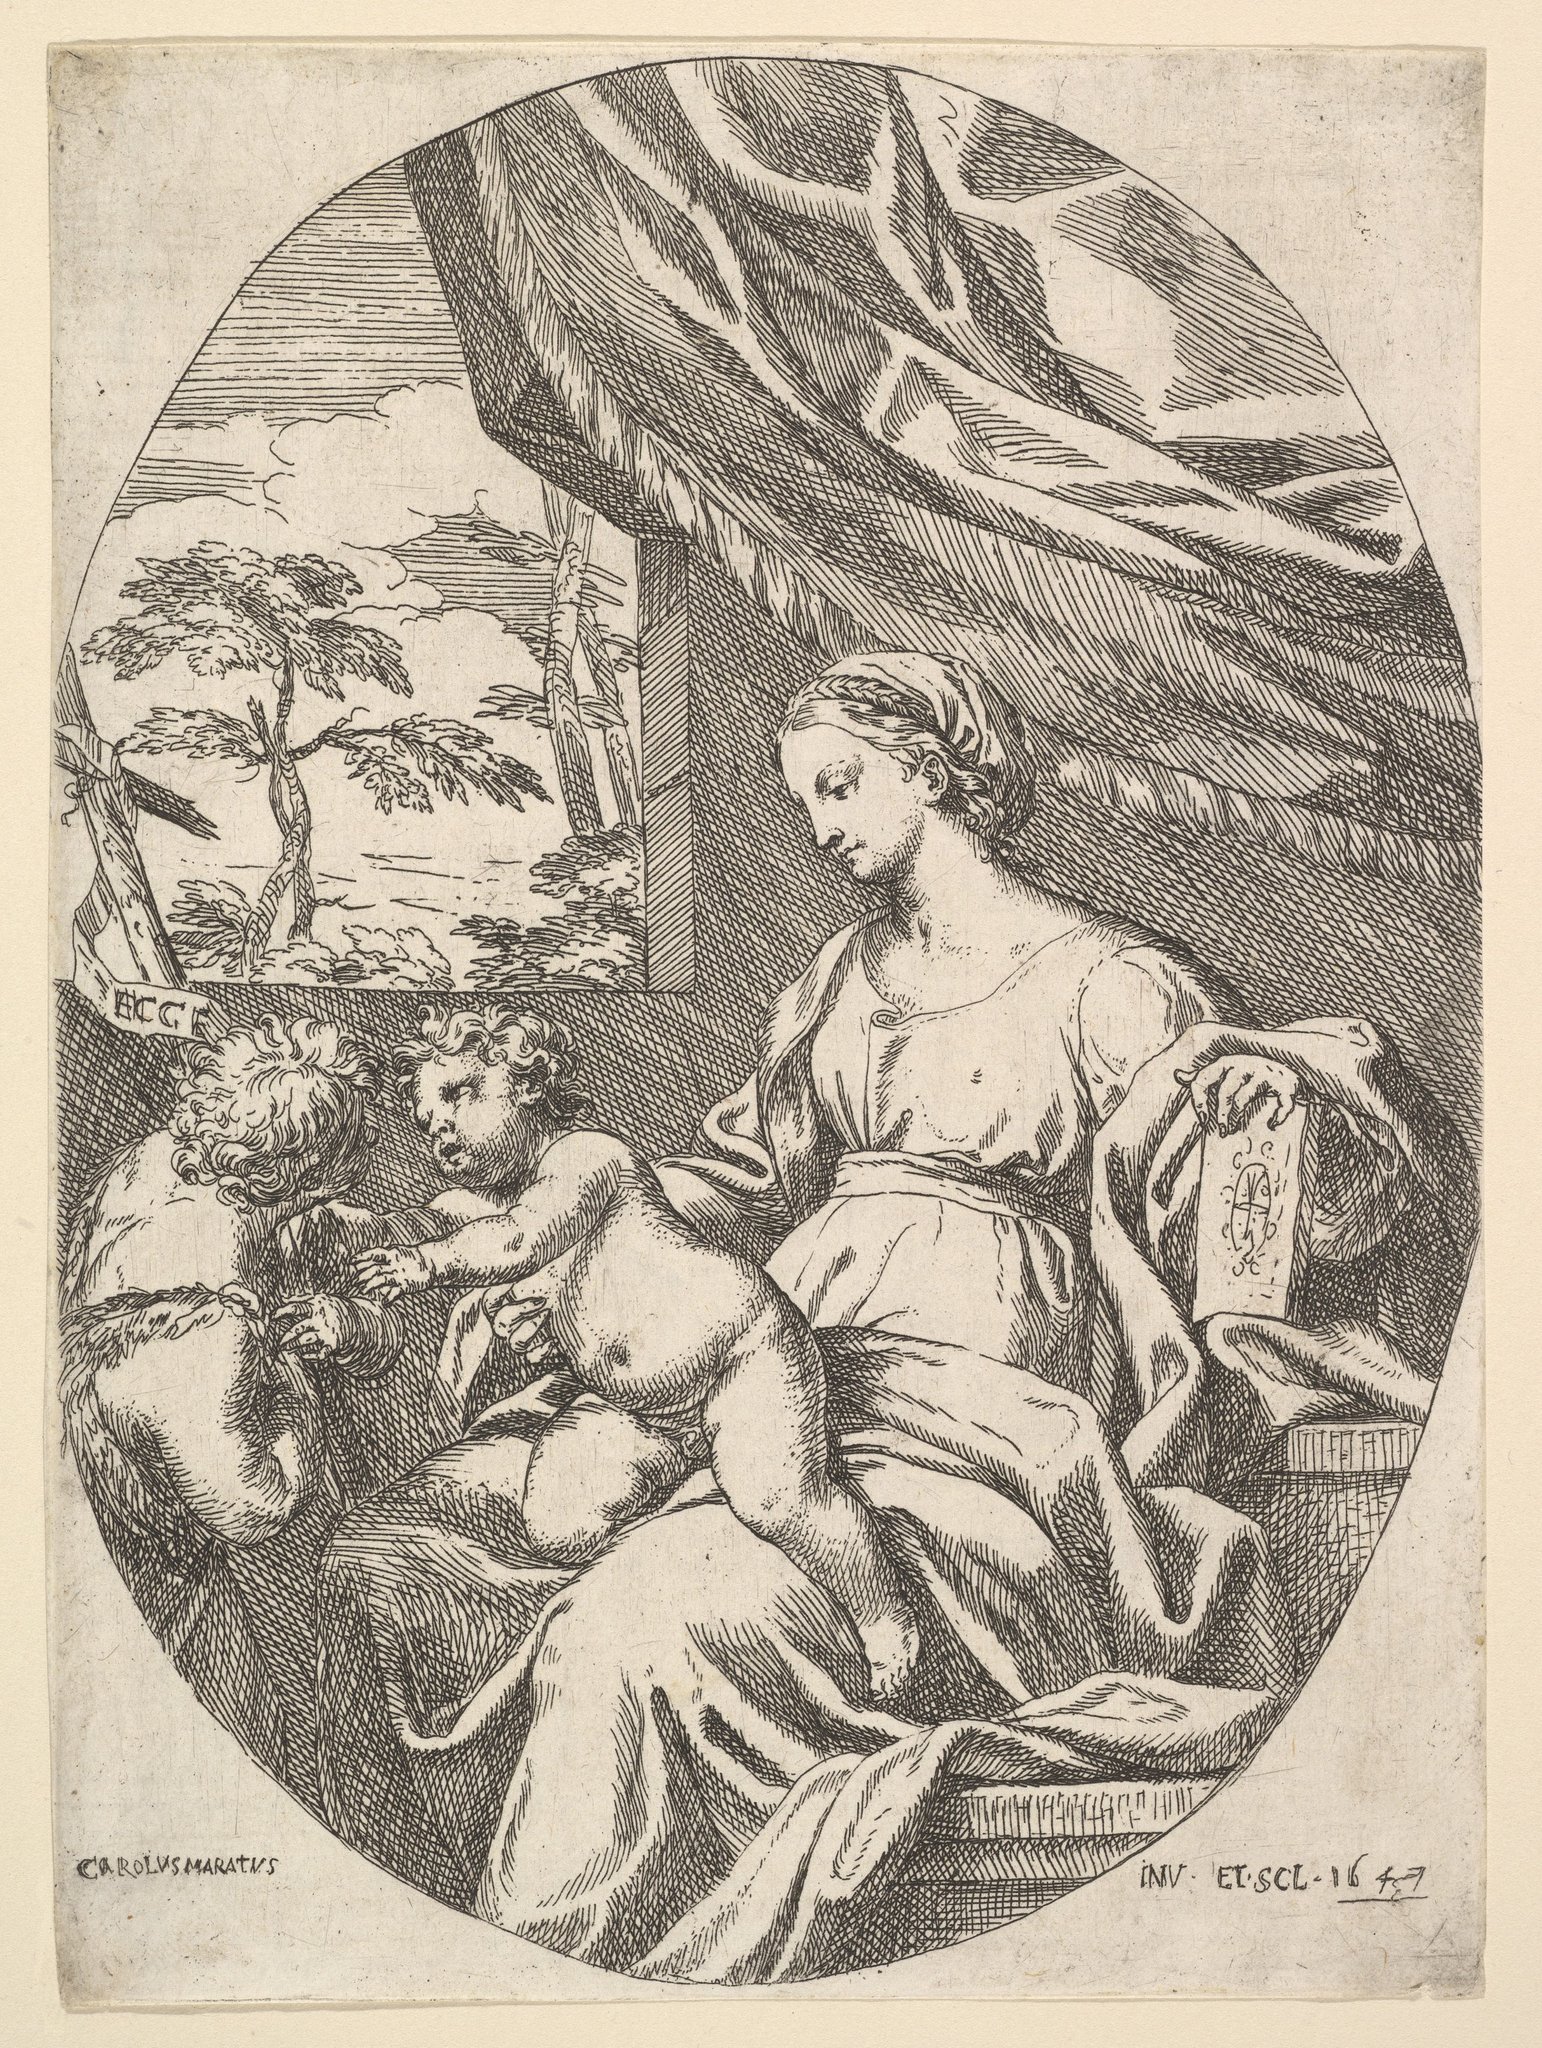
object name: print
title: The Virgin and Child with the Young St. John the Baptist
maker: carlo maratti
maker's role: artist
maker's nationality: italian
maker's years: 1625-1713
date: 1647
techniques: etching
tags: madonna and child,saint john the baptist